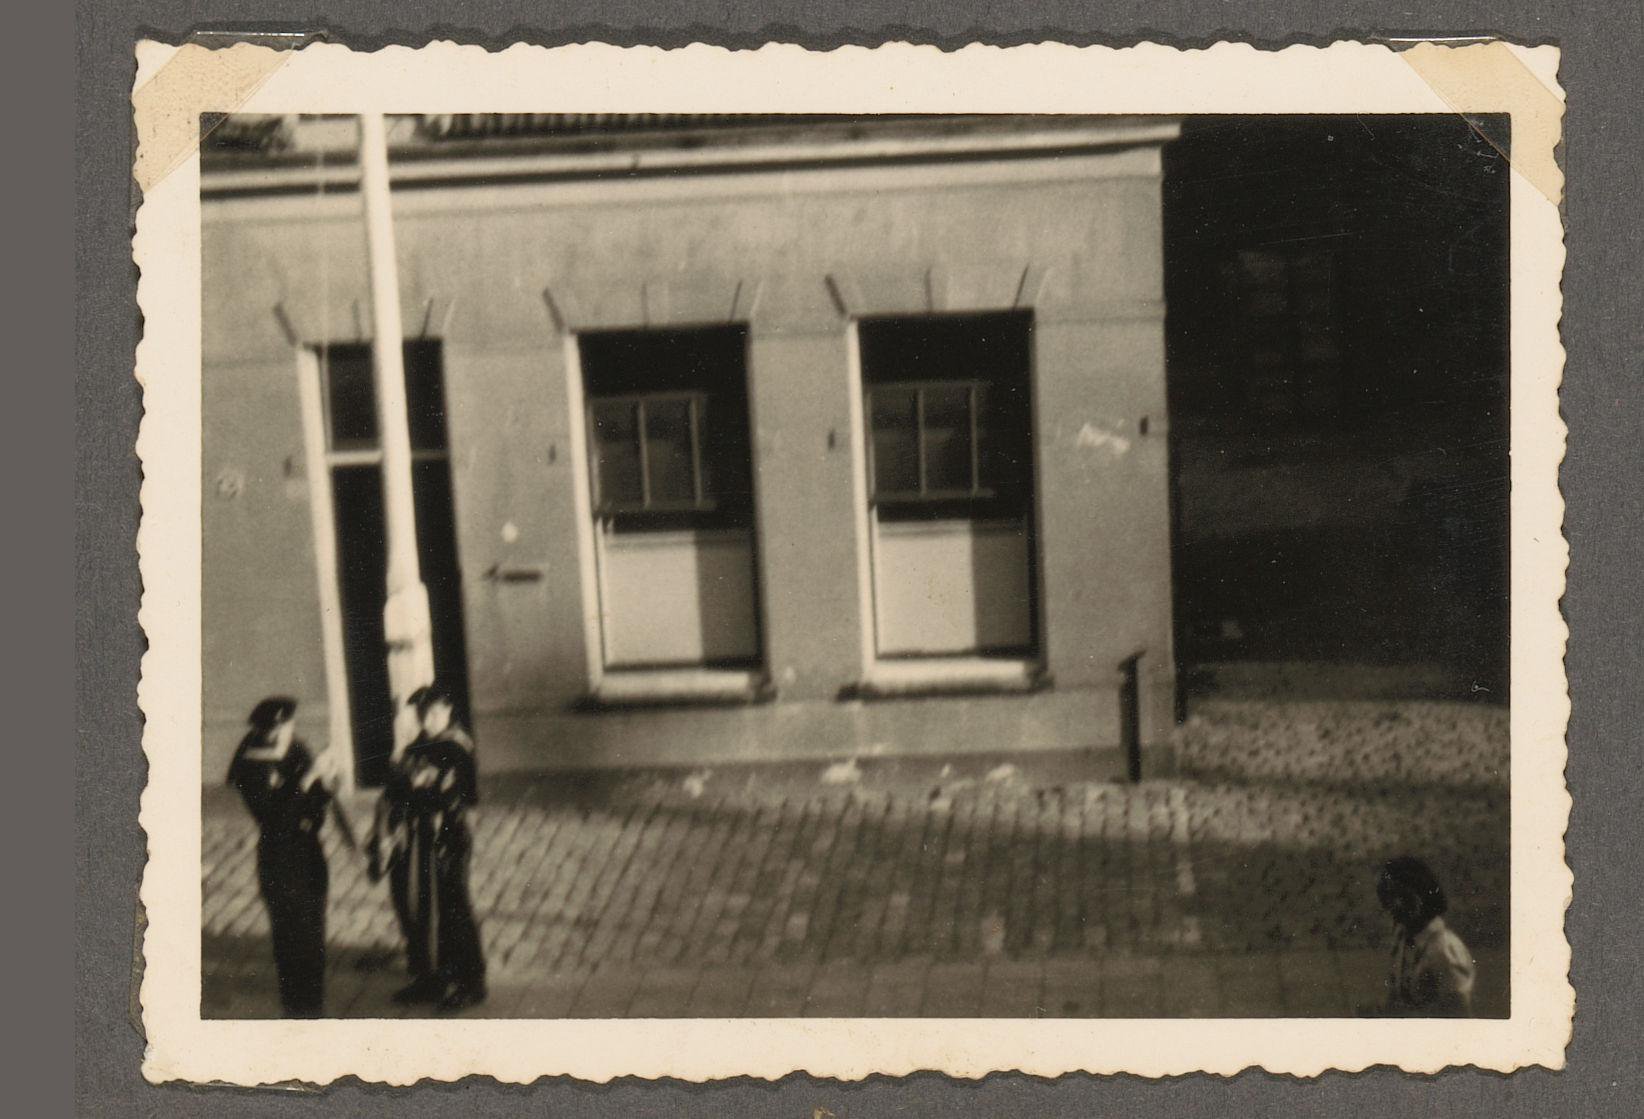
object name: photograph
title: Neerhalen van de Nederlandse vlag en hijsen van de hakenkruisvlag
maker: Anonymous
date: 1941-1945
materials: paper, photographic support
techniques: gelatin silver print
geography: rotterdam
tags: flag display, occupation ~ war, rotterdam